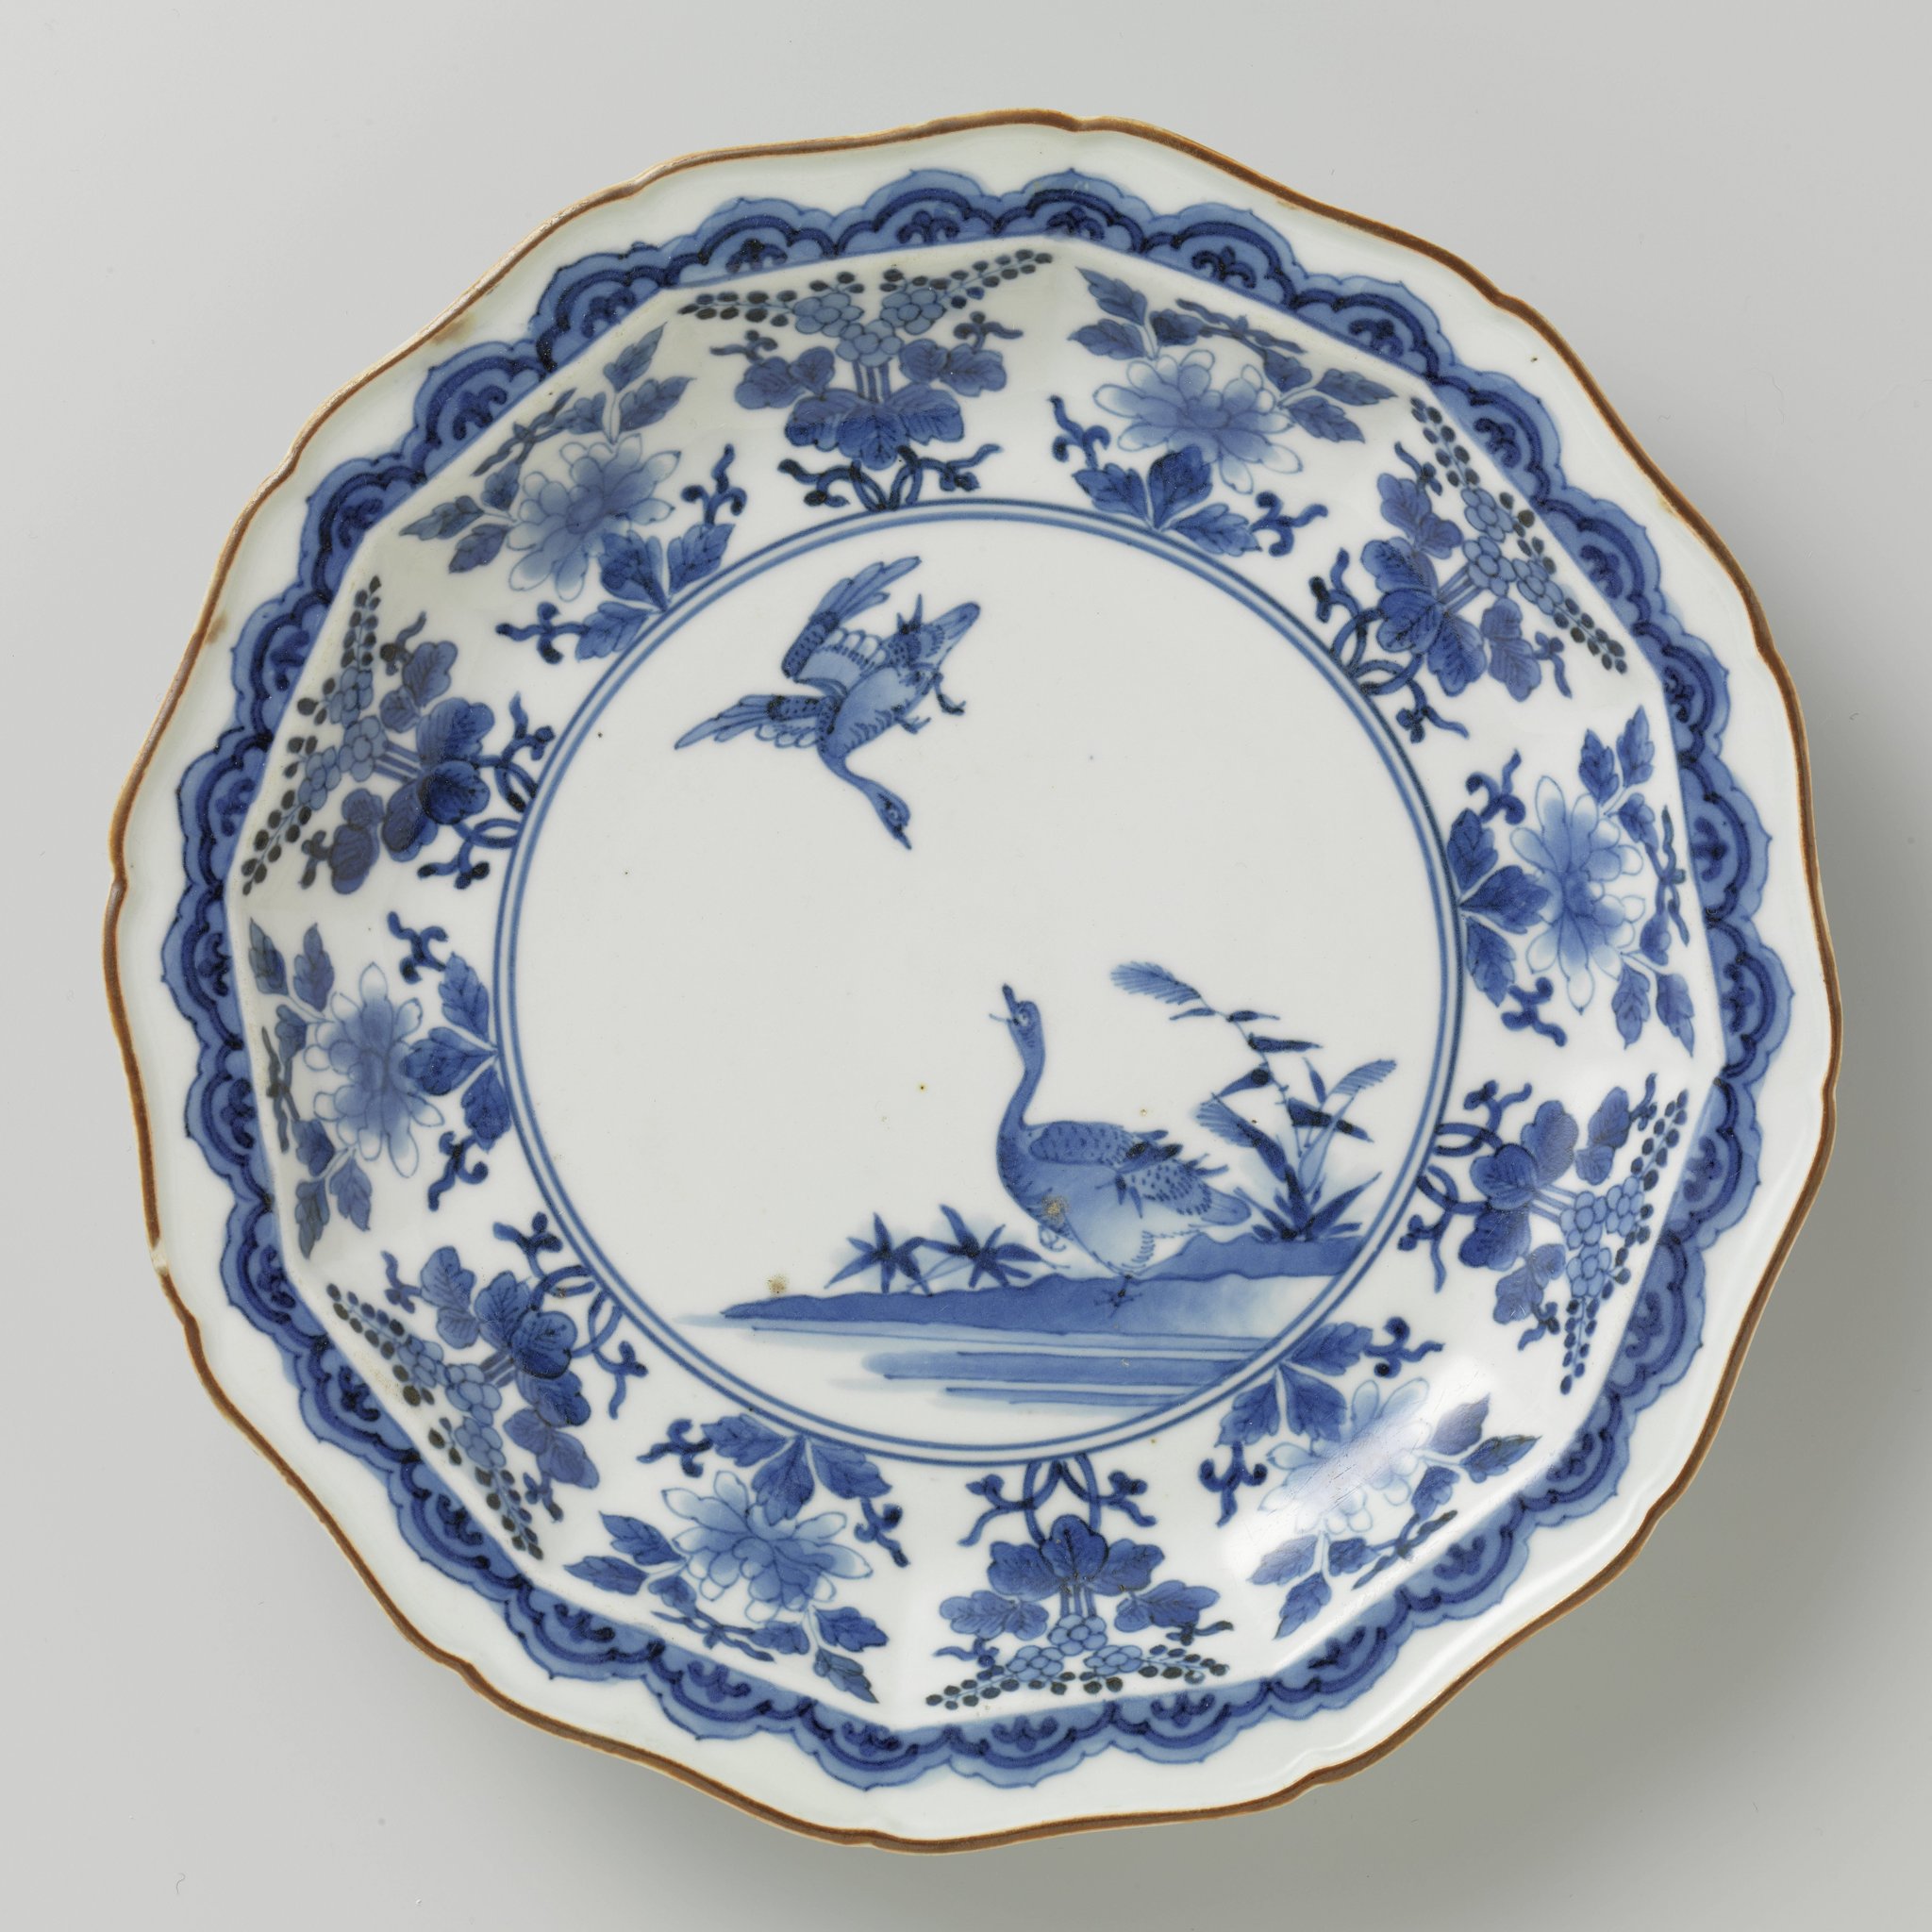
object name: plate dish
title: Twelve-sided plate with geese and flowering plants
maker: Anonymous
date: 1680-1710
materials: cobalt, glaze, paint, porcelain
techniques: firing, turning, vitrification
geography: japan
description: Plate. Kakiemon. Japan, Arita, early 18th century. Porcelain, decoration in underglaze blue.